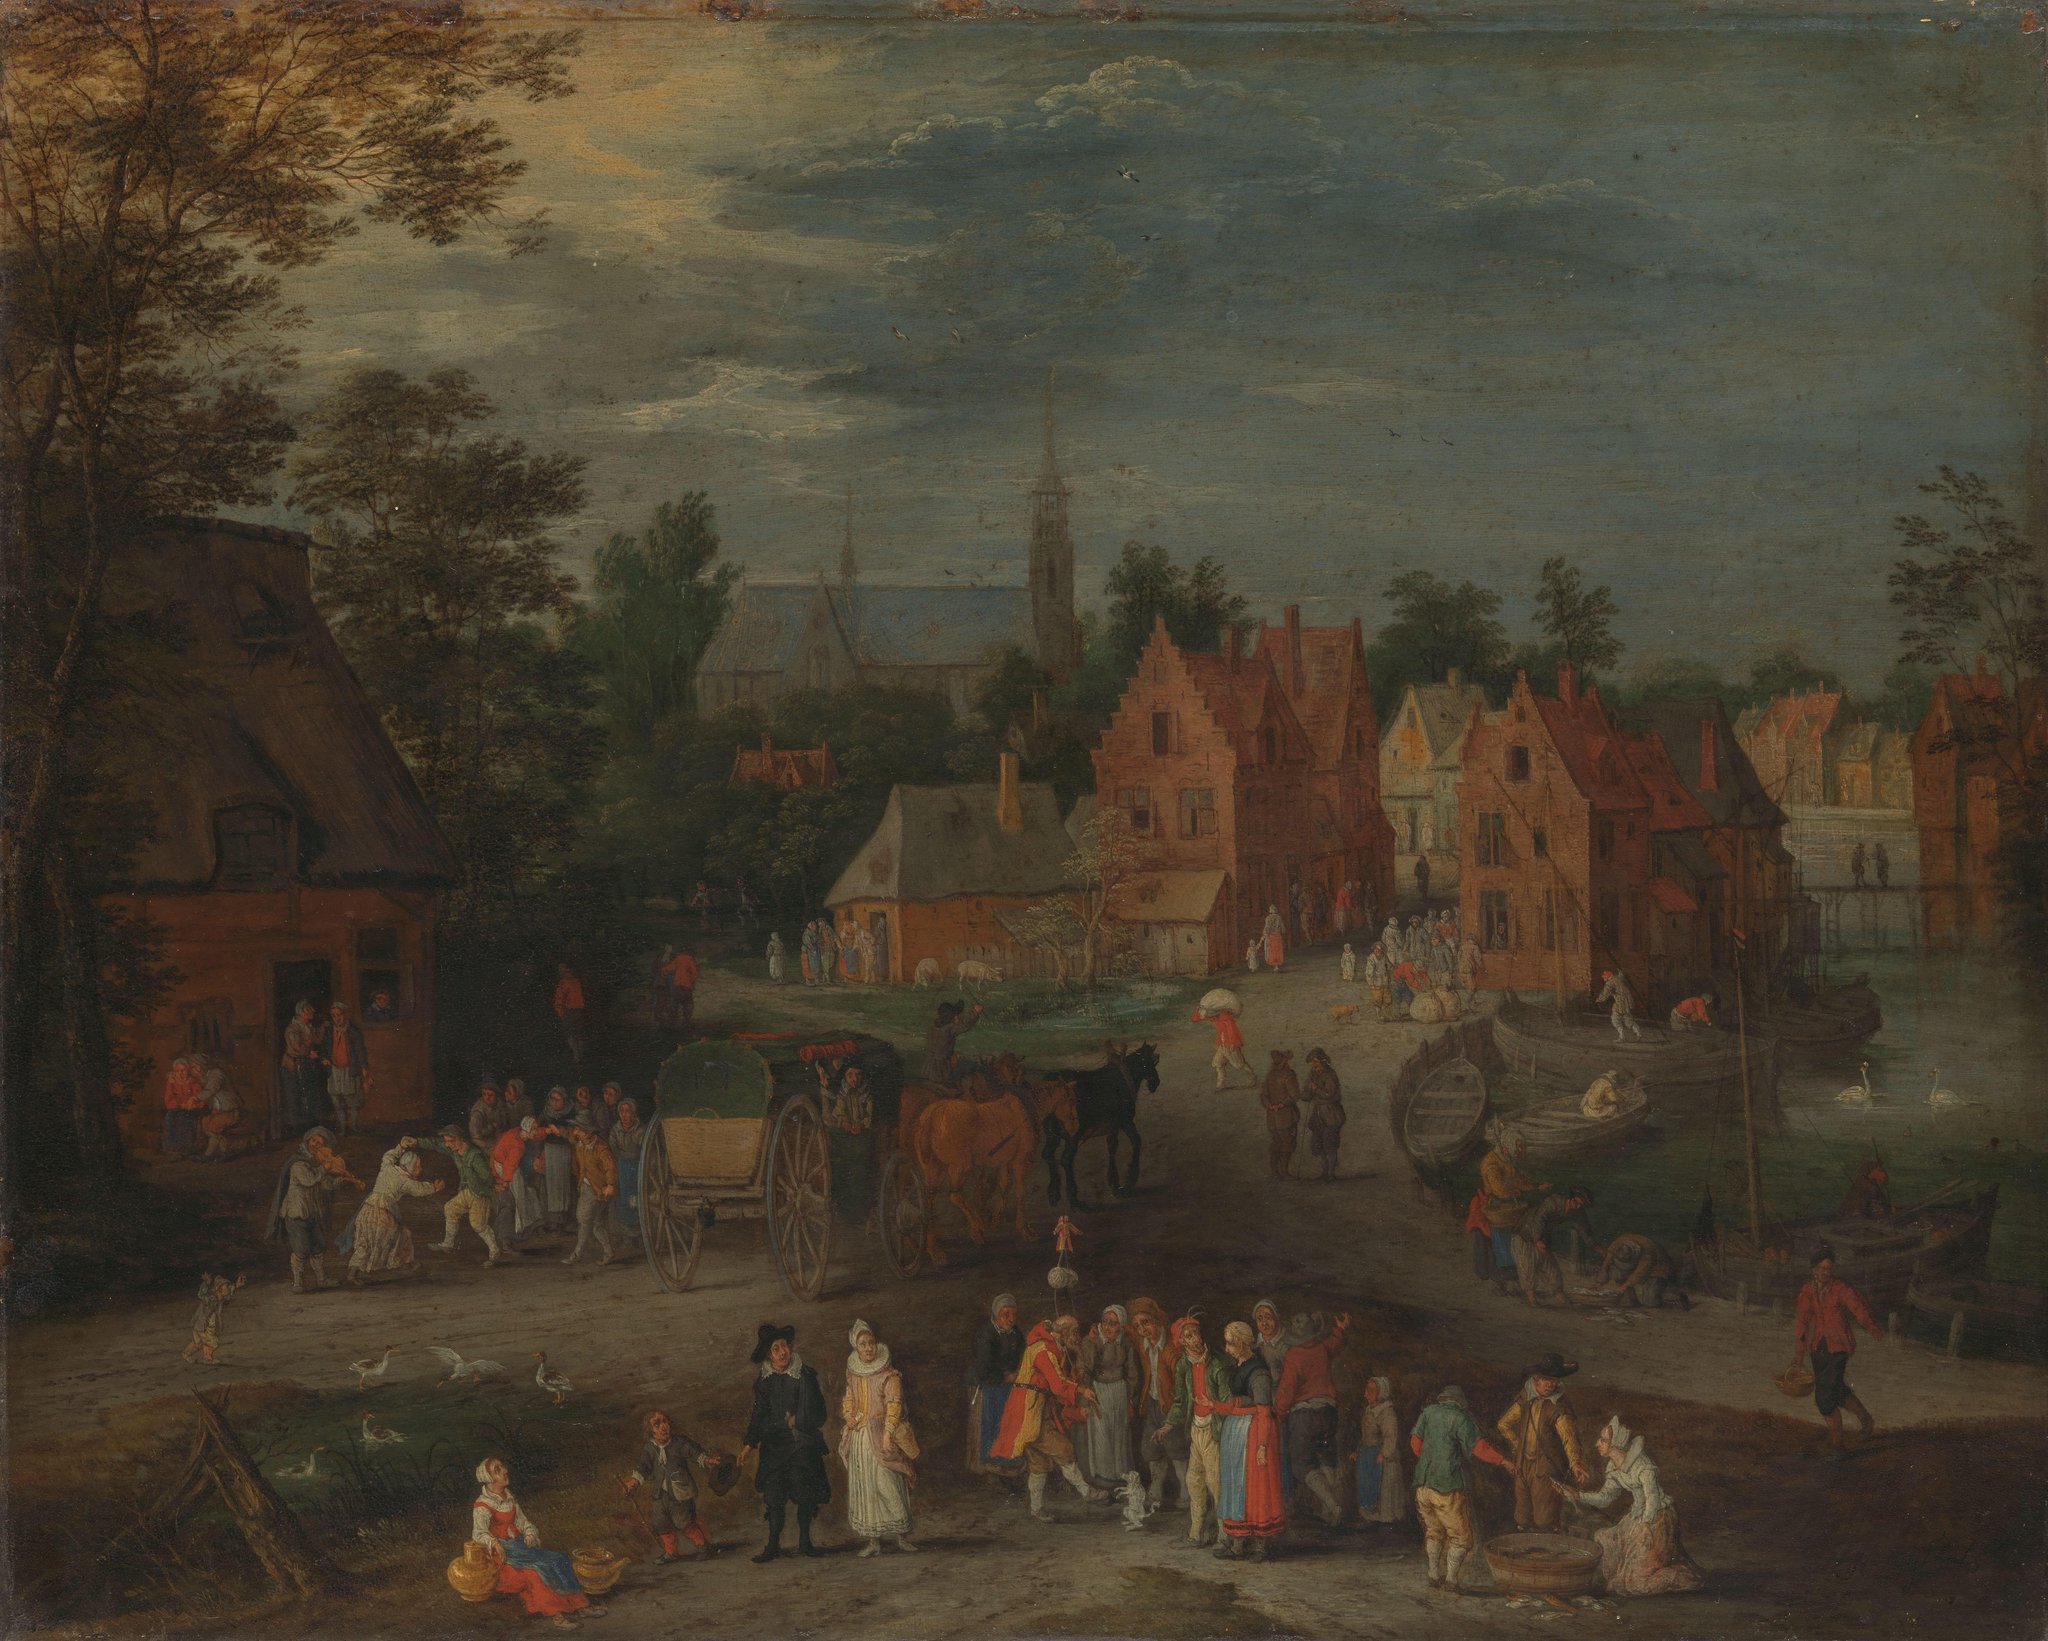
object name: painting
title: Village with a Puppeteer Entertaining a Small Crowd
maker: peeter gijsels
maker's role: draughtsman, painter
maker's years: 1621-1690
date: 1650-1660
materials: copper, oil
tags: public road in village, pavement, terrace in front of inn or restaurant, more than one couple dancing, dogs (circus performance), earning money with other animals, dog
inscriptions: signature, bottom right: ‘p:Gijs[?]sels’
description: Gezicht in een Vlaams dorp. Op de voorgrond staat een groep toeschouwers rond een man met een dansende hond, rechts verkoopt een vrouw vis. Links dansende boeren voor een herberg waarlangs een huifkar rijdt. Meer naar achteren loopt de weg langs een water met boten tussen de huizen van het dorp. In de verte een kerk.